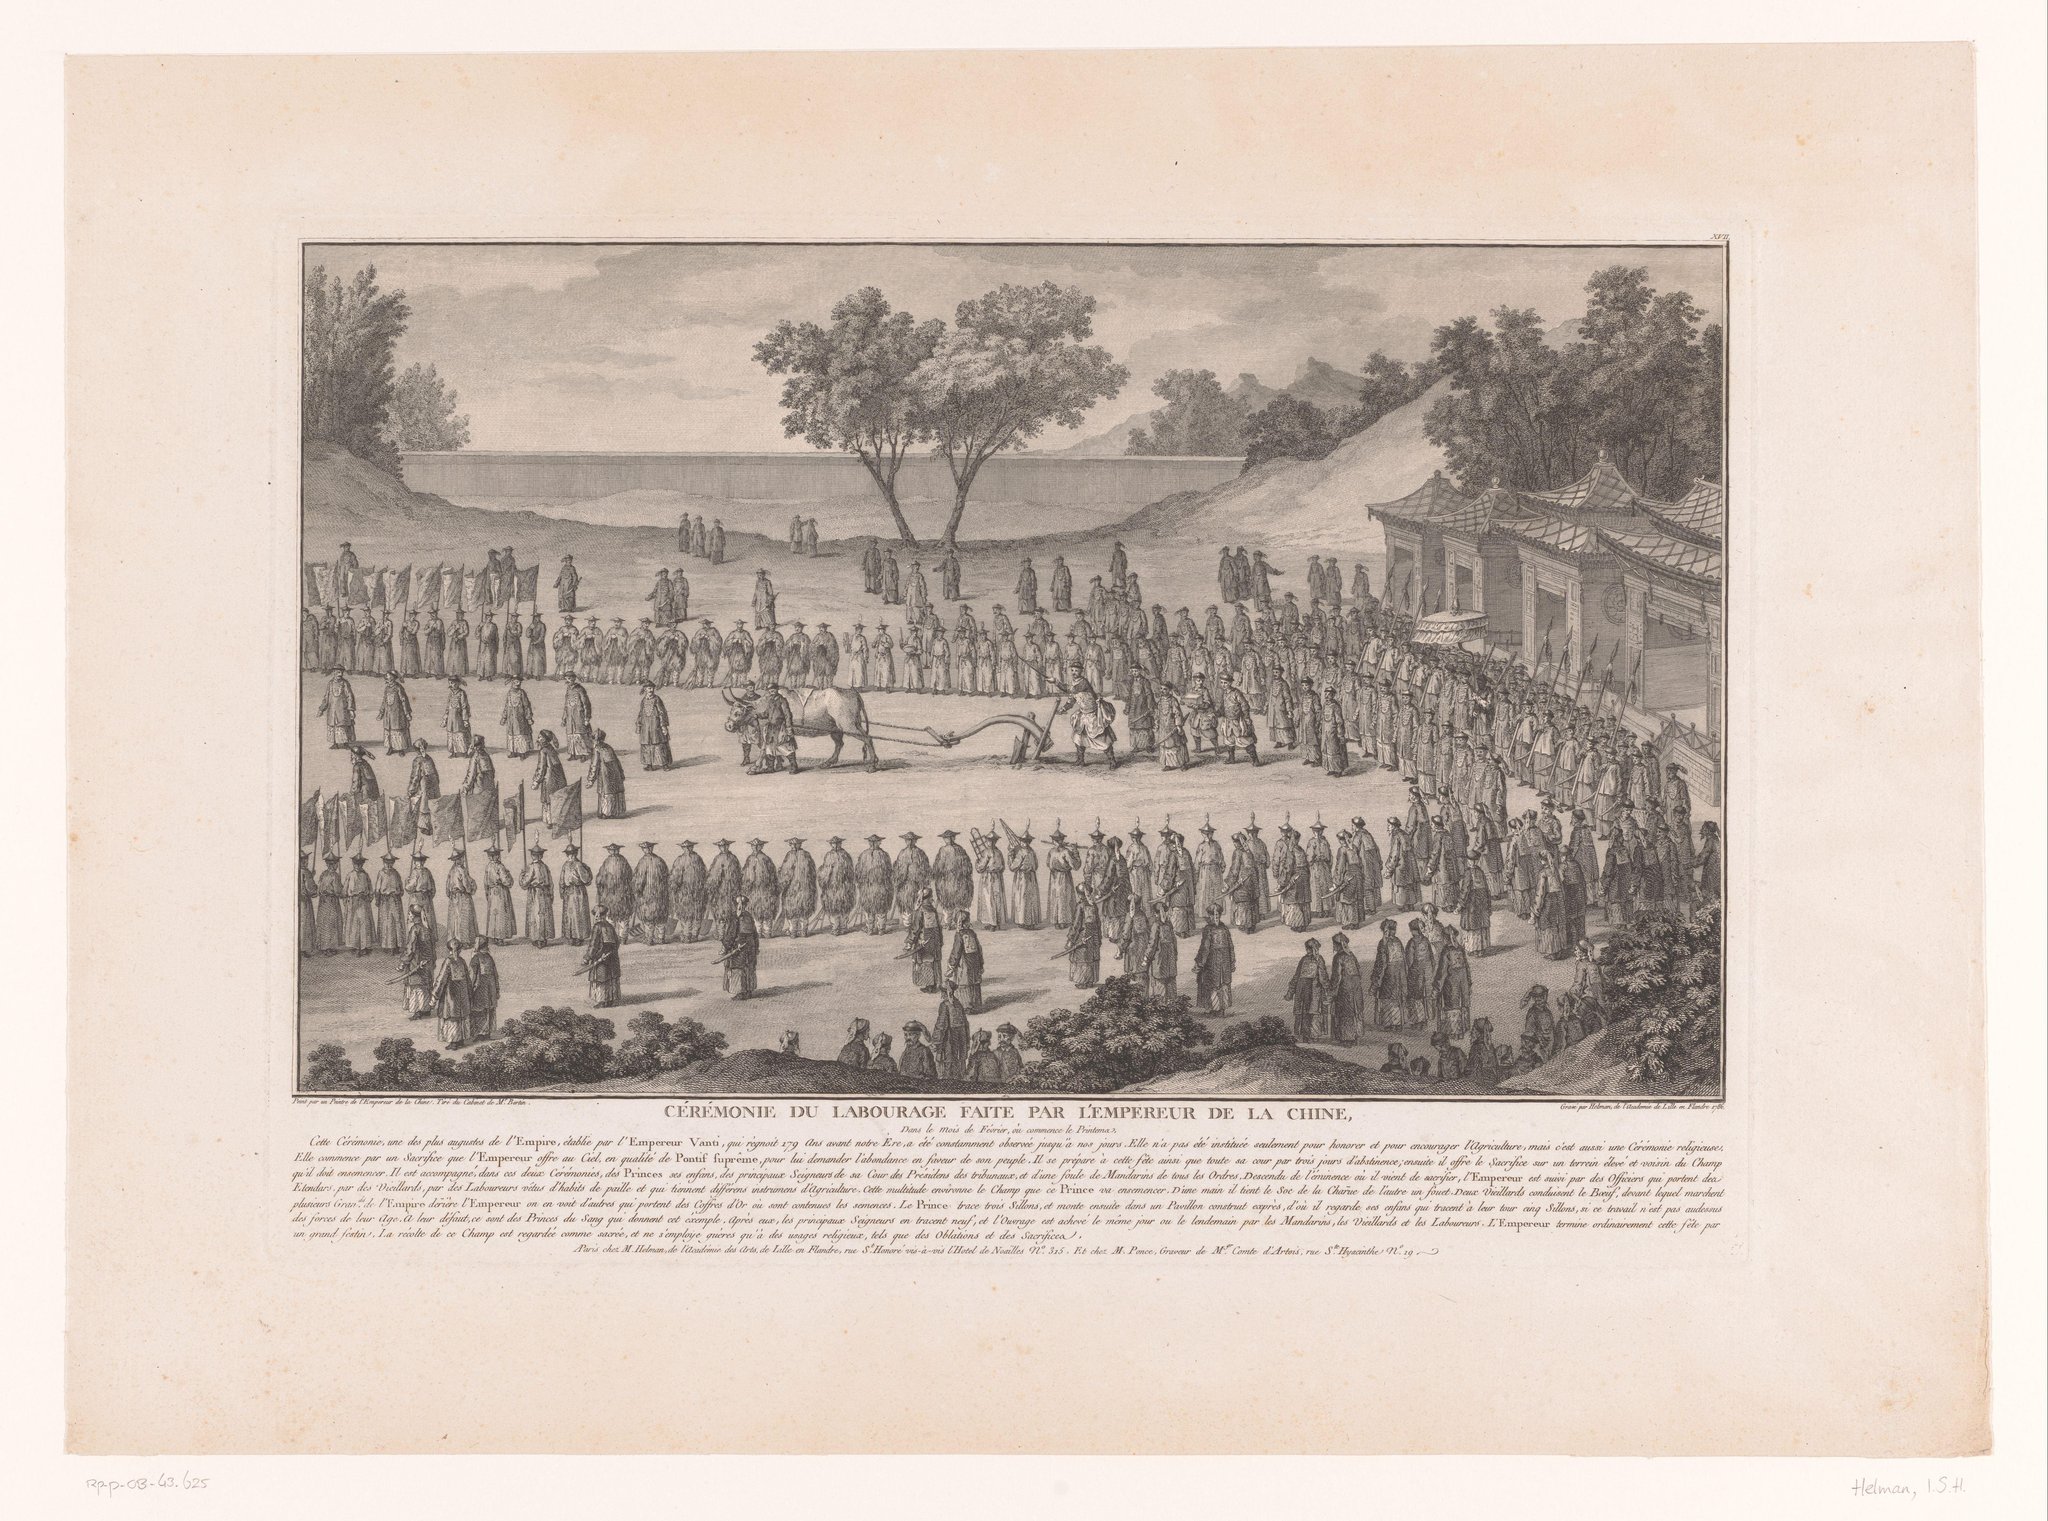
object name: print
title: Conquêtes de l'Empereur de la Chine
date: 1786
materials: paper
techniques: engraving, etching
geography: france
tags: court ceremonial, court etiquette, historical persons, ploughing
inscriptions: collector's mark: Lugt 2228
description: Prent uit een versie van de serie 'Conquêtes de l'Empereur de la Chine' met afbeeldingen van de veroveringen van keizer Qianlong van China, uitgegeven door Helman tussen 1783-1785. Voor twee bladen met bijbehorende beschrijvende tekst, zie RP-P-OB-43.629 en RP-P-OB-43.630.